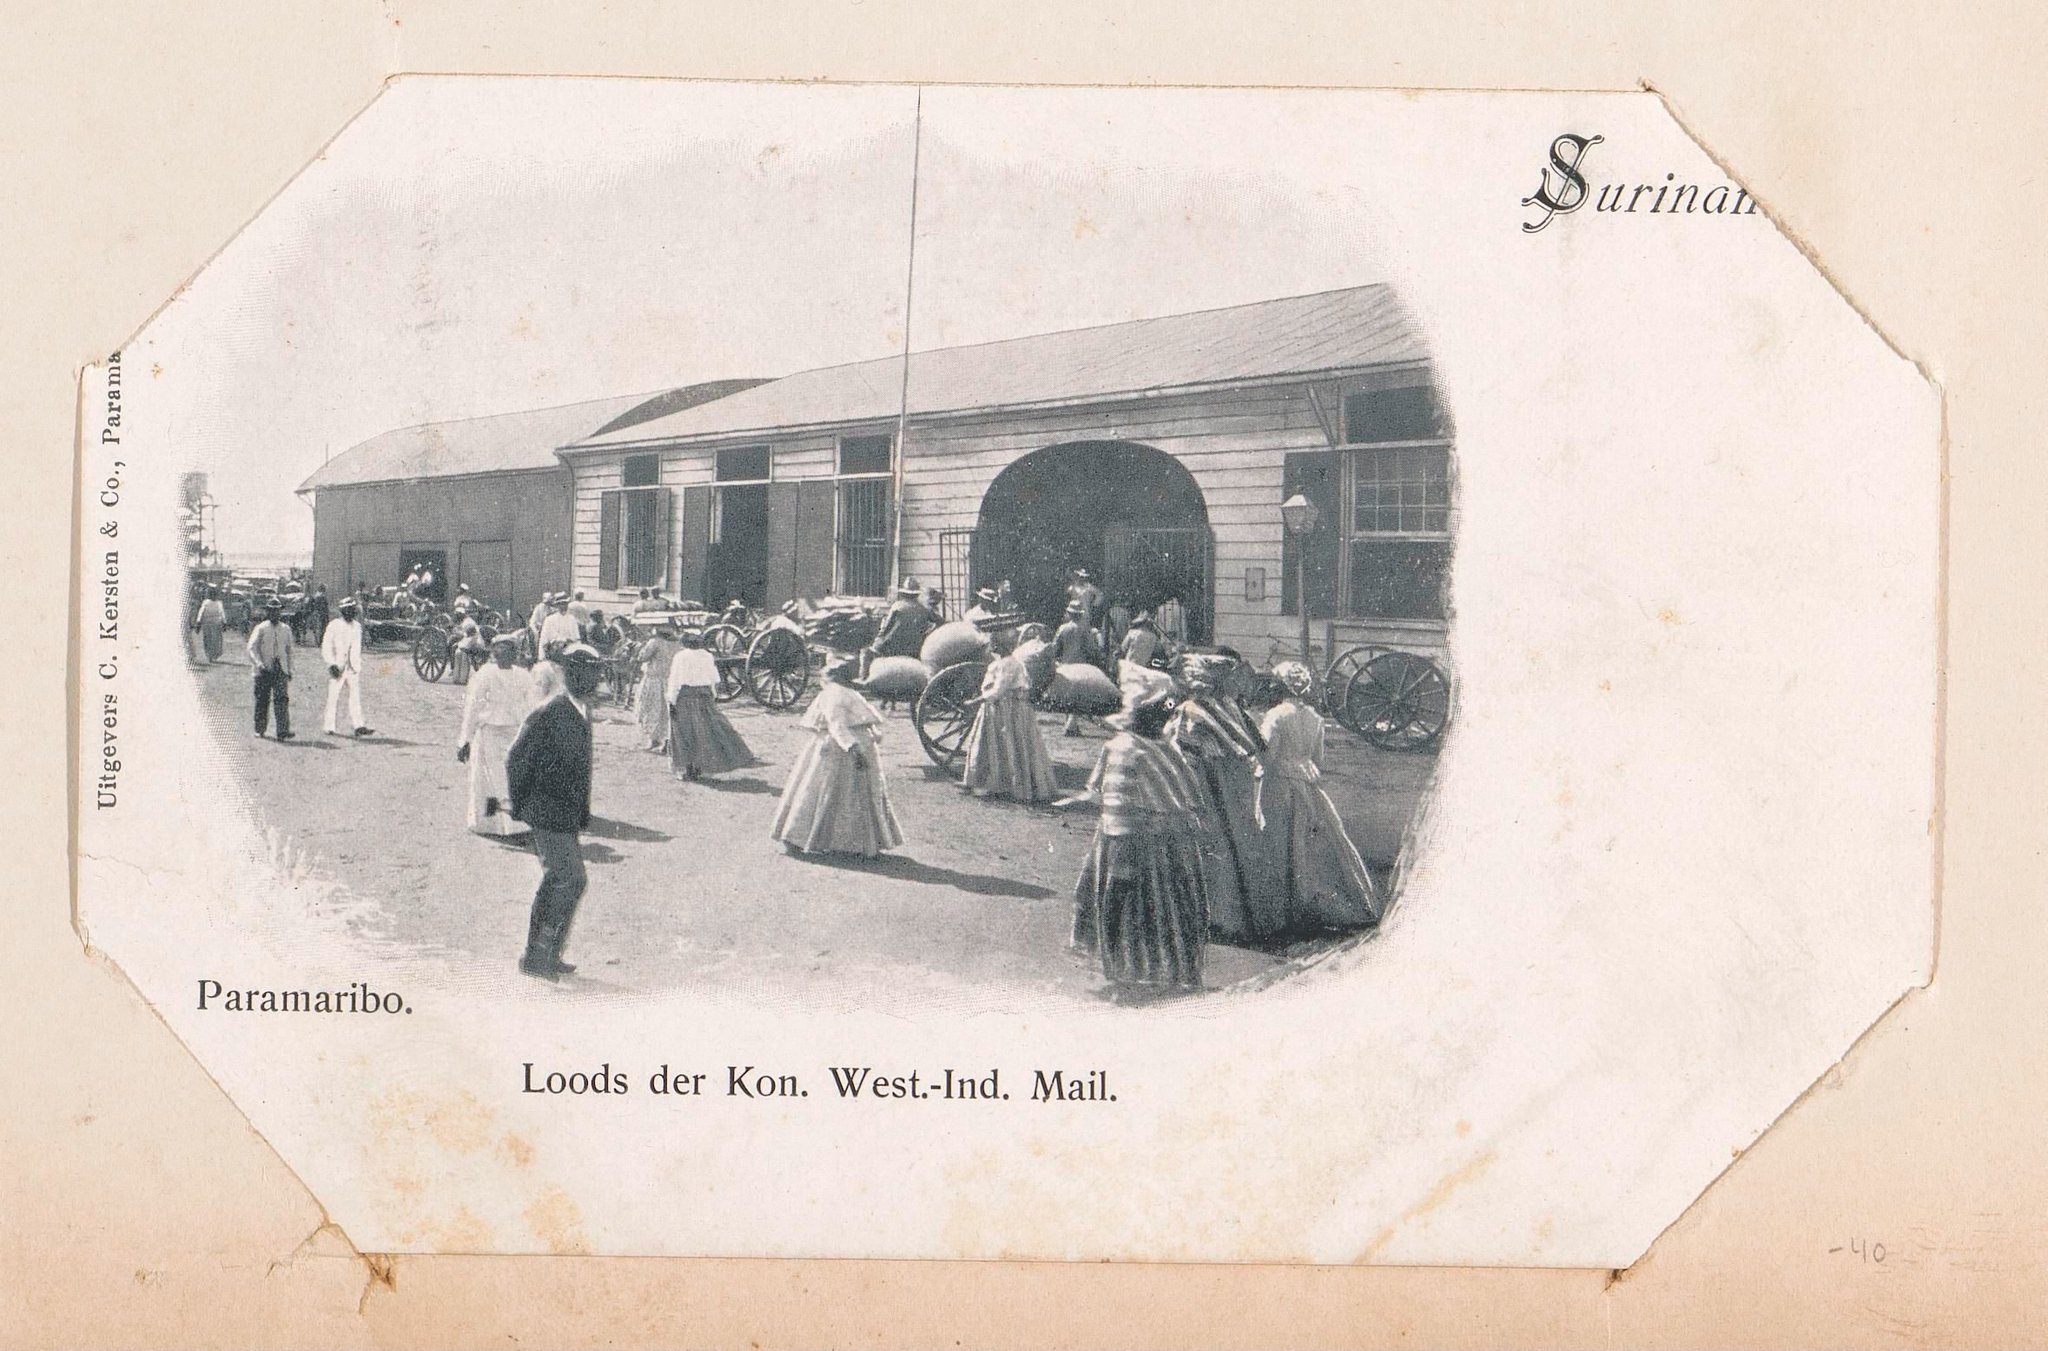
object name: ansichtkaart, prentbriefkaart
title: Loods van de Koninklijke West-Indische Maildienst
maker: Anonymous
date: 1900-1910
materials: cardboard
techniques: autotype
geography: paramaribo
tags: warehouse (~ harbour)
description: Personen en goederen voor een pakhuis van de Koninklijke West-Indische Maildienst in Paramaribo. Onderdeel van een verzameling van 68 briefkaarten uit Suriname, bijeengebracht in een album als aandenken aan een verblijf in Suriname in september 1911.